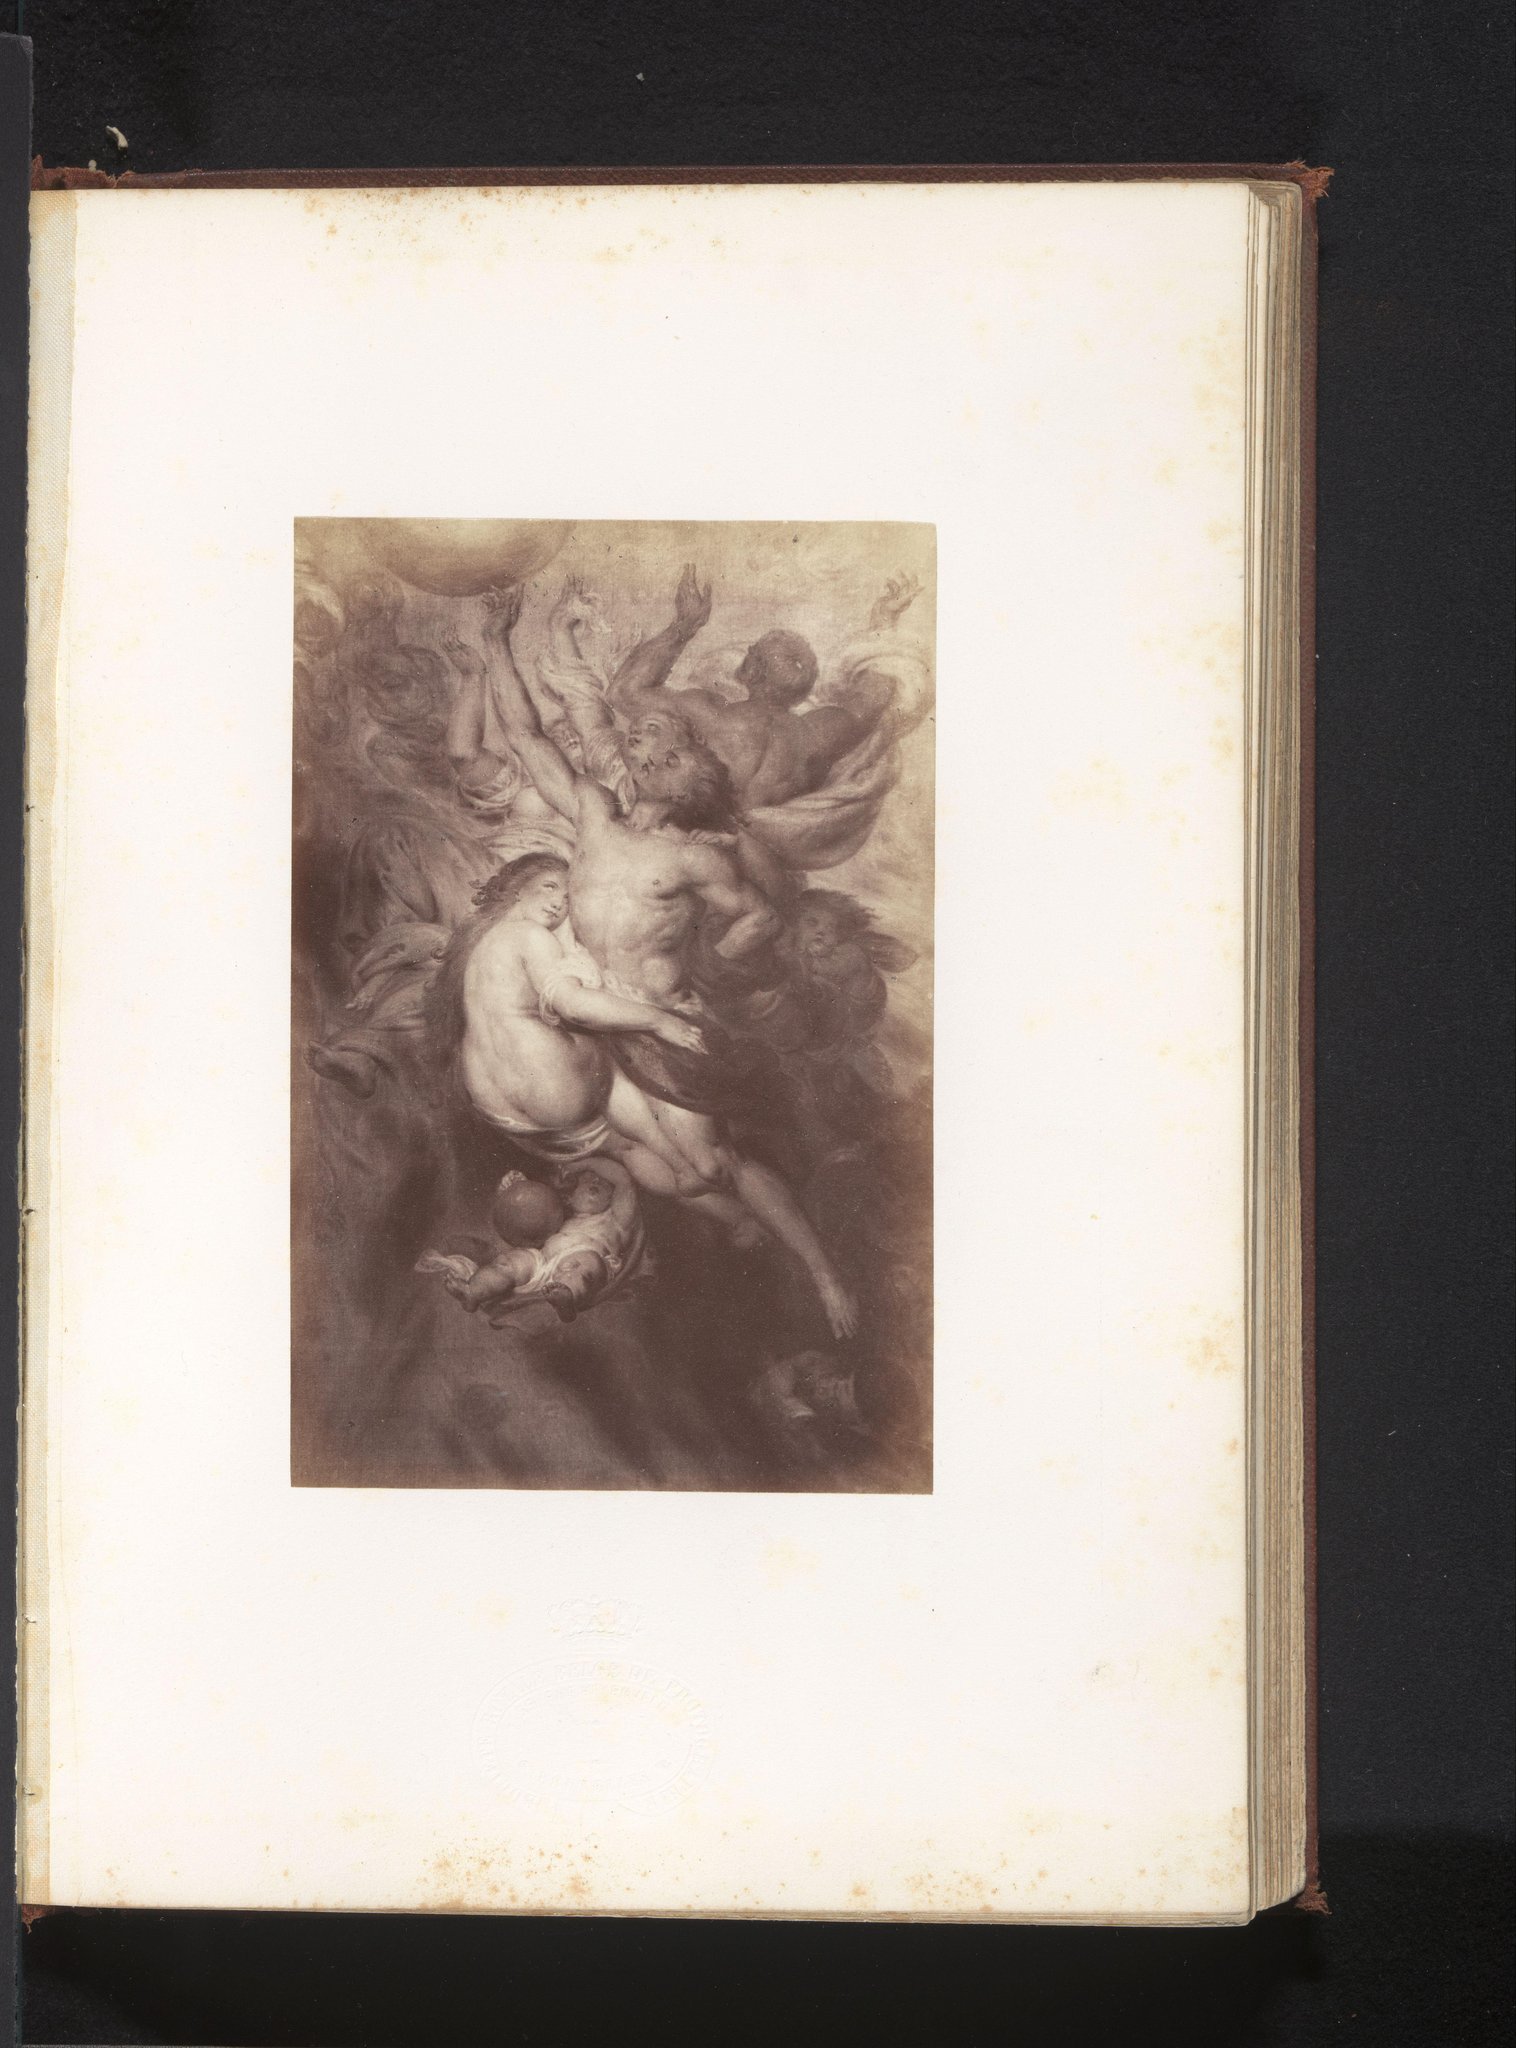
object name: page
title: Fotoreproductie van De menselijke macht kent geen grenzen door Antoine Wiertz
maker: edmond fierlants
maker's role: fotograaf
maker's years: 1819-1869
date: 1863-1868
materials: photographic support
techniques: albumen print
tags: human beings with superhuman powers or achievements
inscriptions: check stamp: ‘SOCIÉTÉ ROYALE BELGE DE PHOTOGRAPHIE/ 69, RUE KEYENVELD/ BRUXELLES’